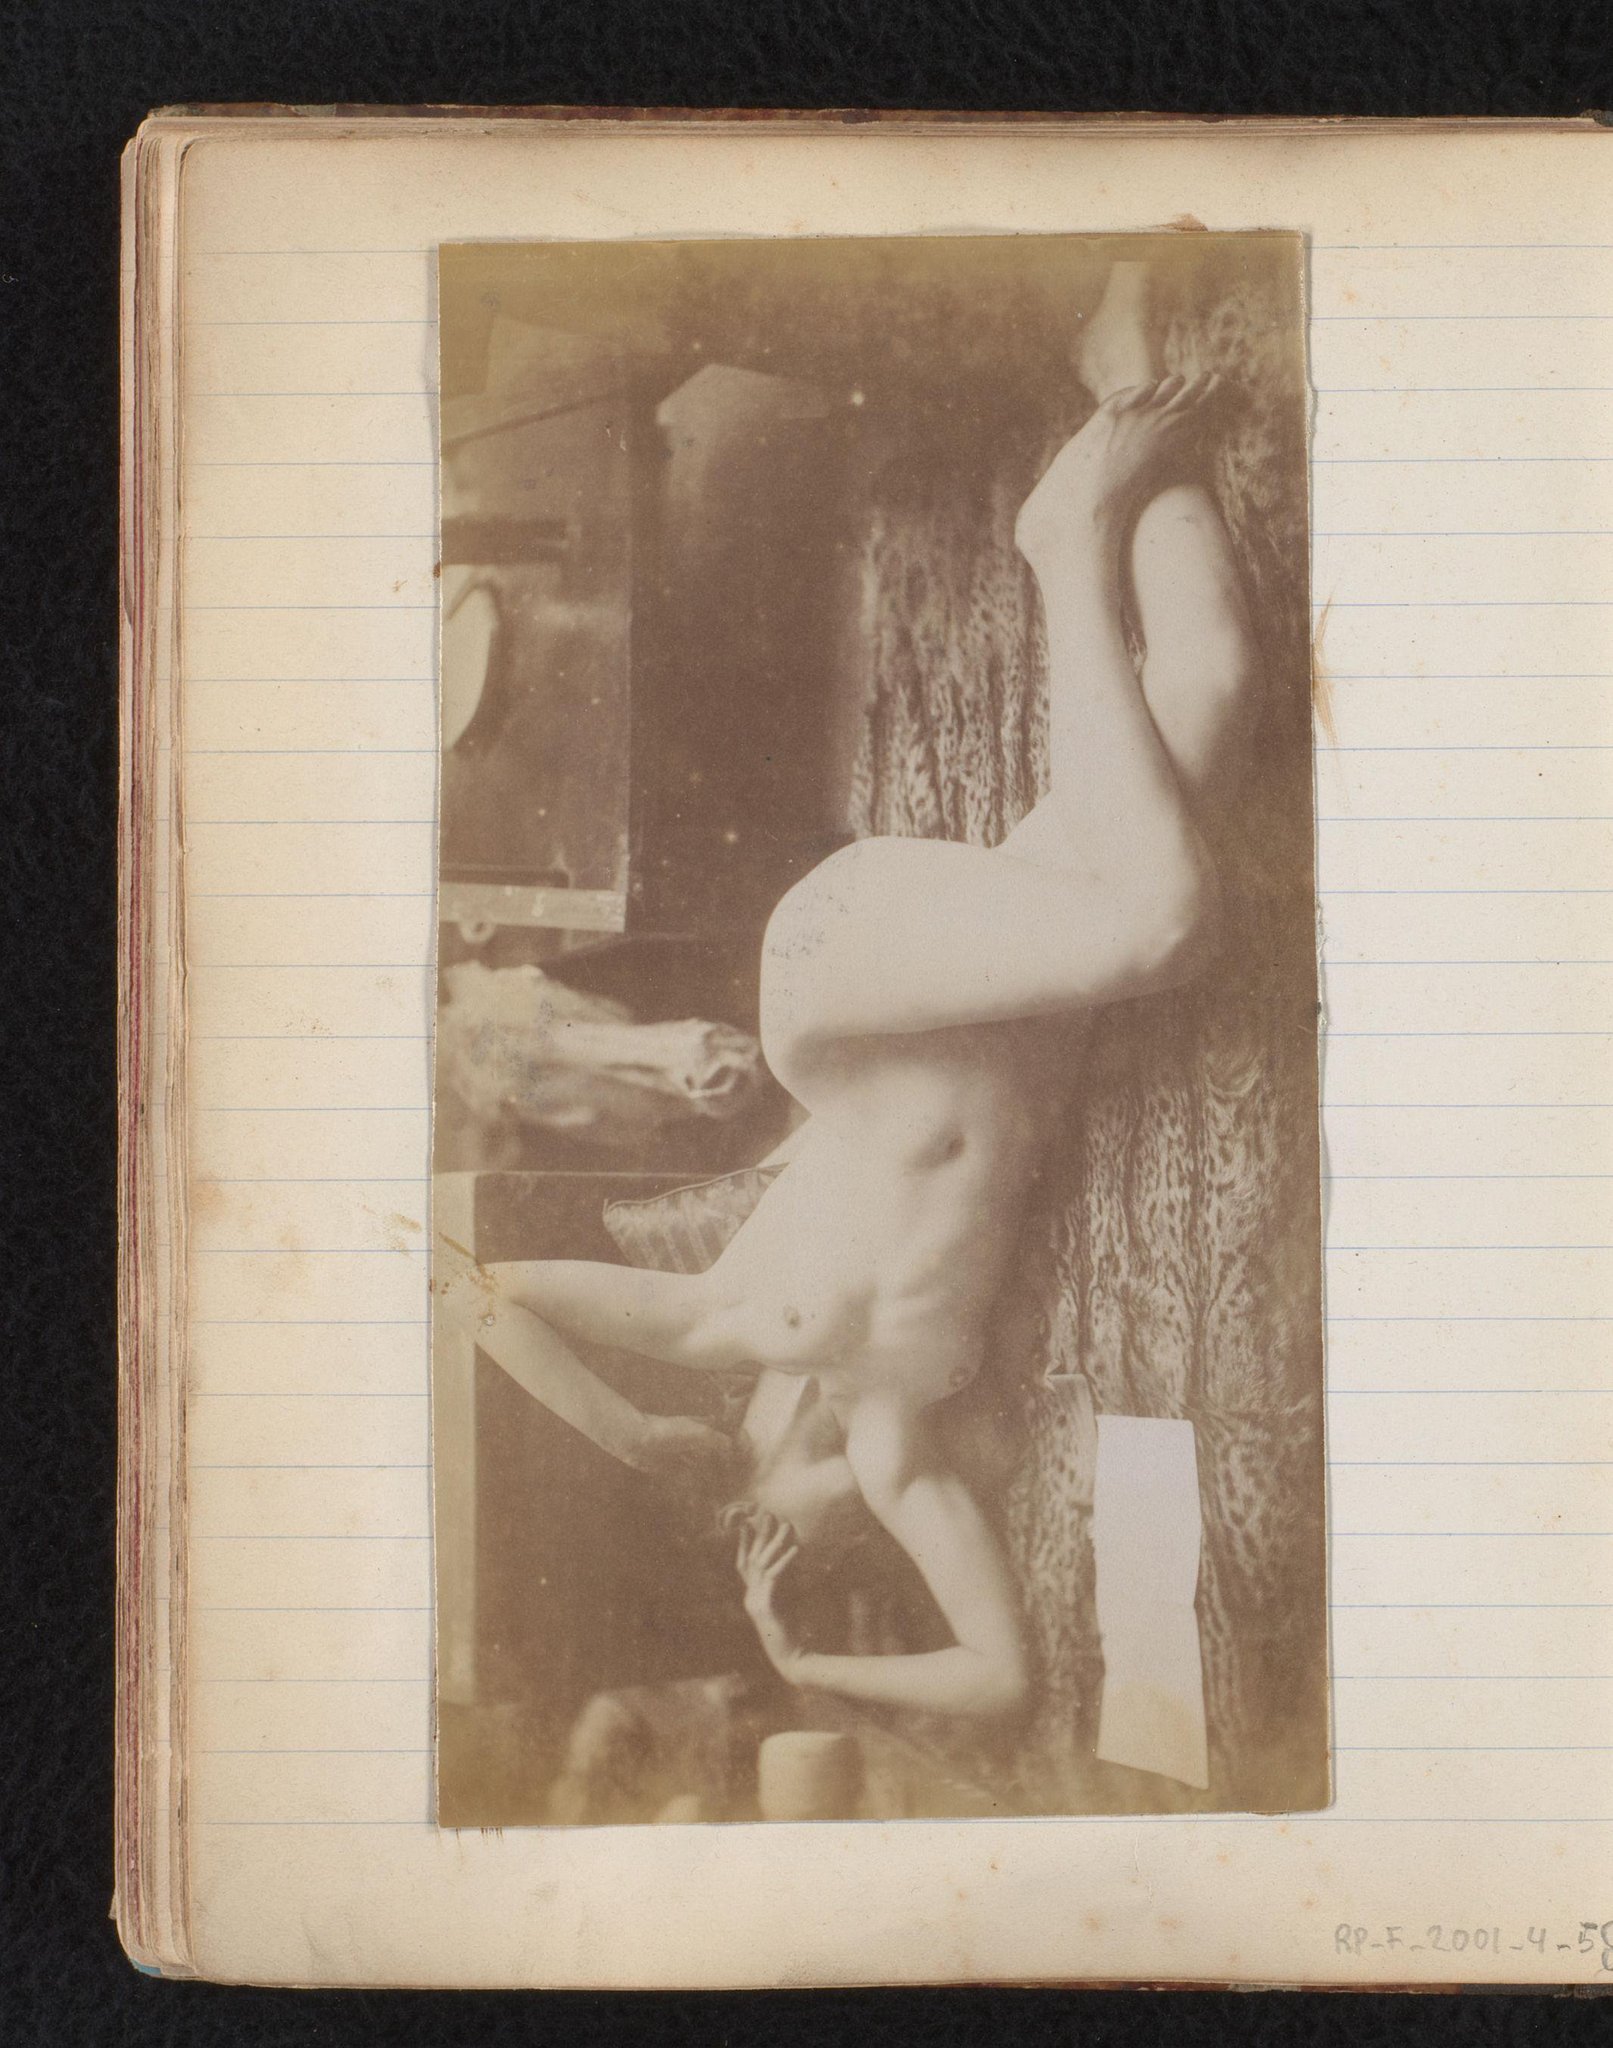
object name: album leaf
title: Studie van een vrouwelijk naaktmodel, liggend op een tijgervel, in het atelier van Jacques de Lalaing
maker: jacques lalaing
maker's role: painter, sculptor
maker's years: 1858-1917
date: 1883-1914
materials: photographic support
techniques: albumen print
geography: brussels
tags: adult woman, the (nude) human figure; 'corpo humano' (ripa) (+ lying), artist (in general) working from nude model